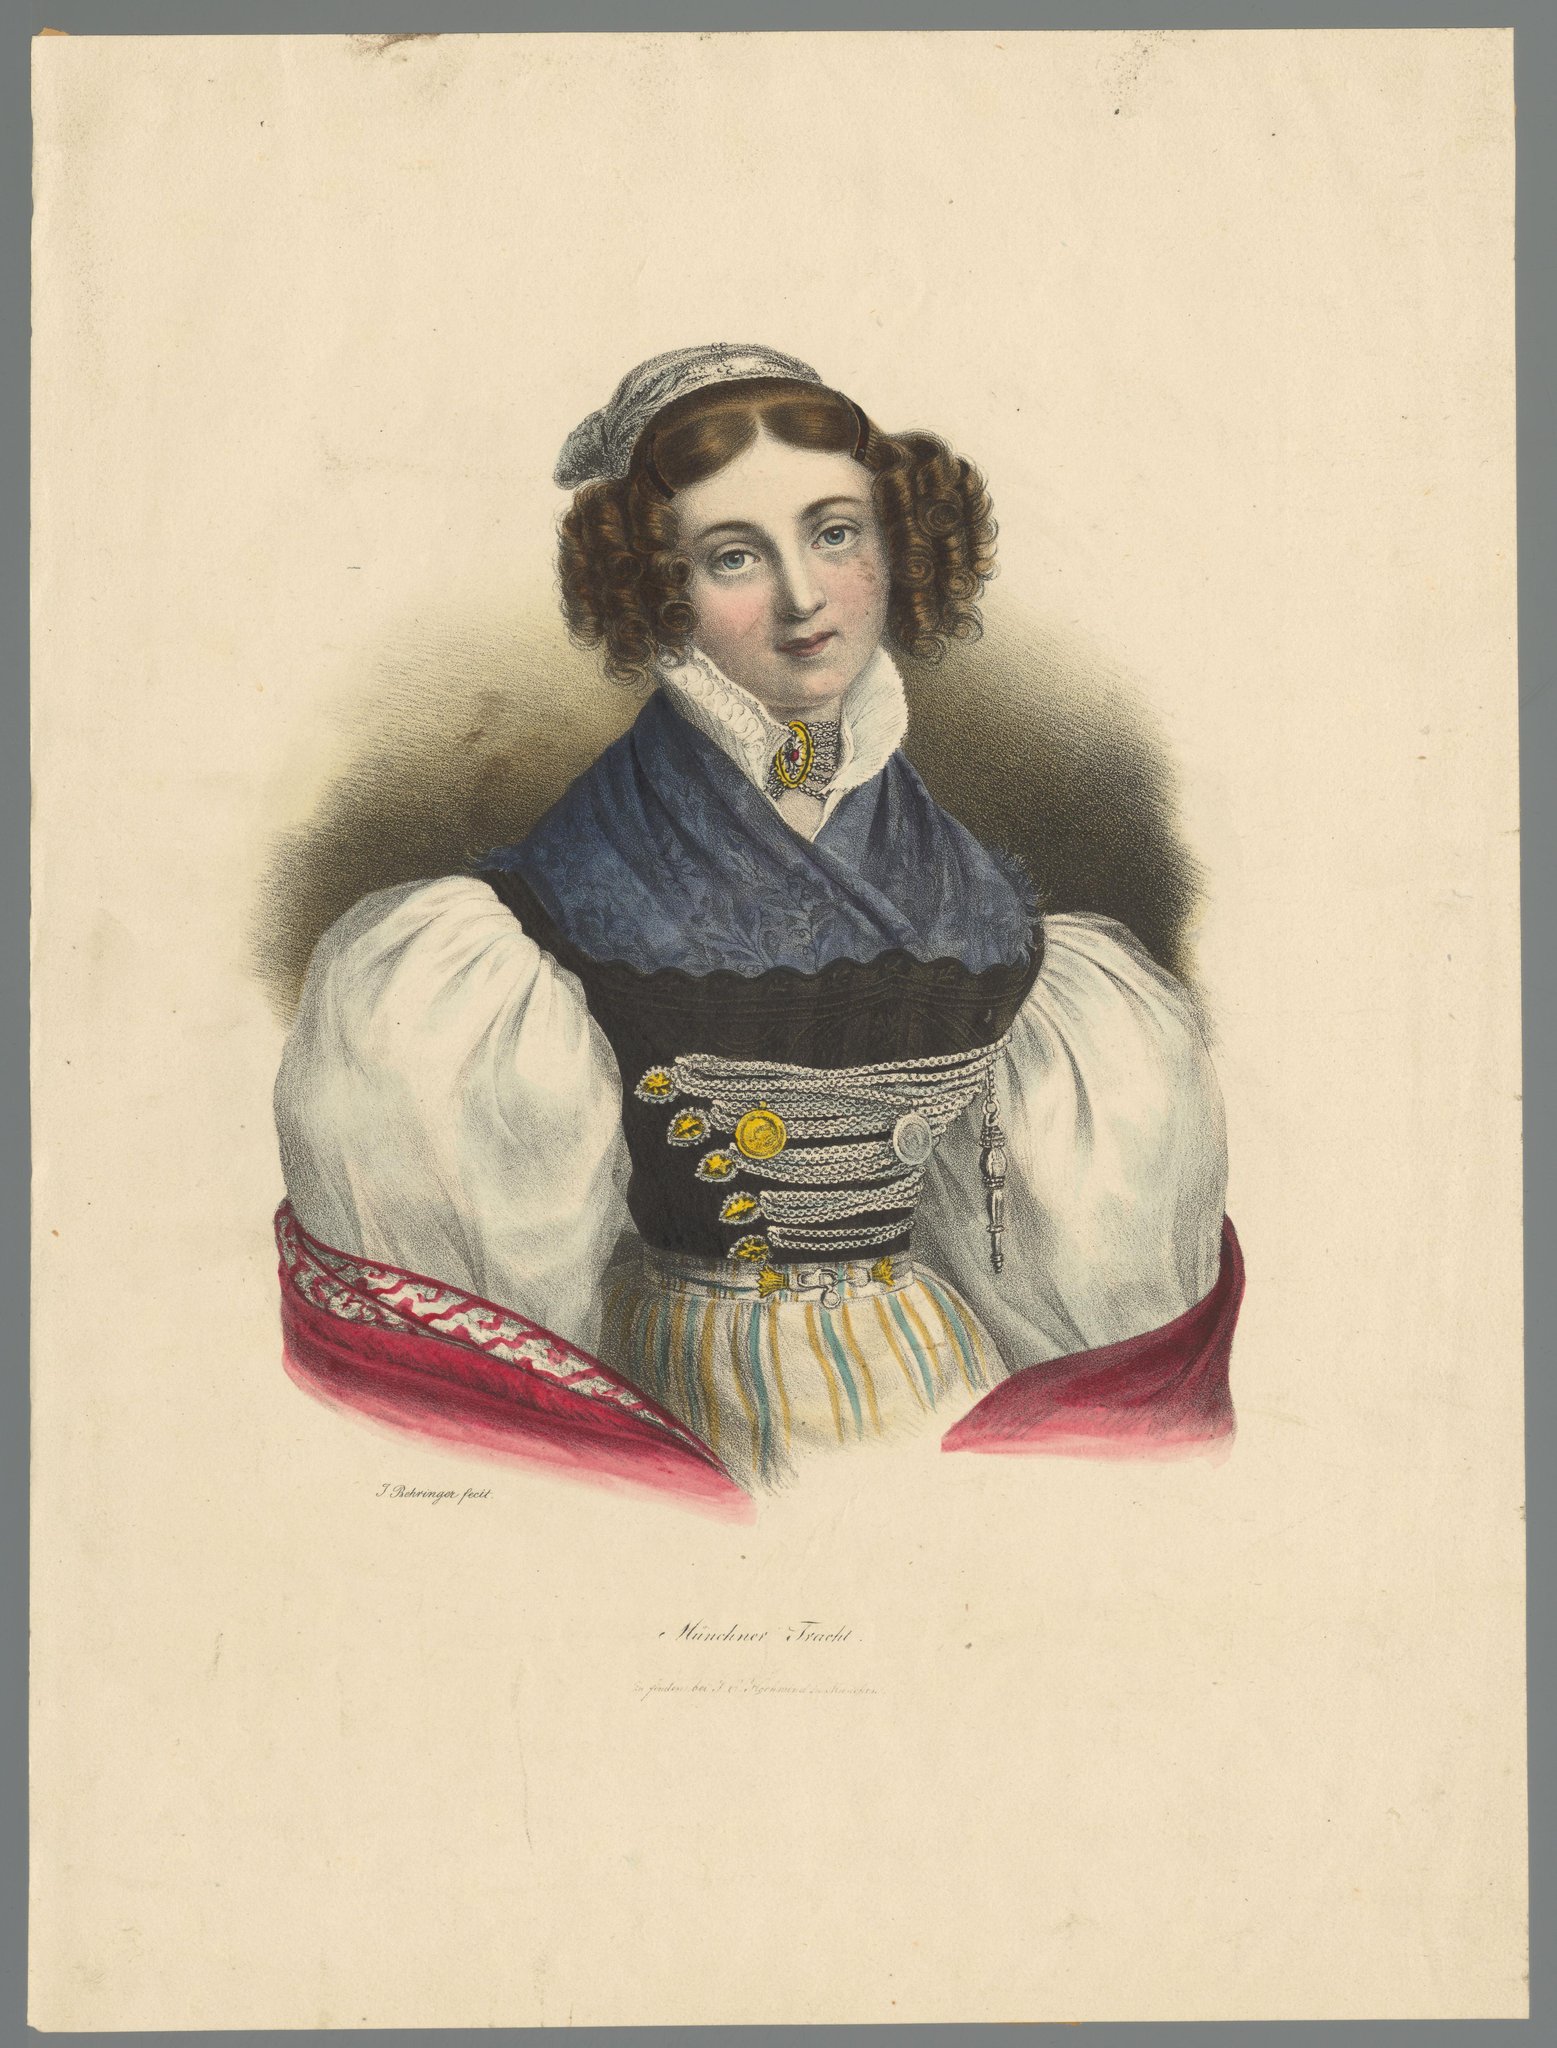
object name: print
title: Vrouw in klederdracht uit München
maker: johann christian hochwind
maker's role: publisher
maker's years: -1854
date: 1825-1875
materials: paper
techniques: hand coloring, lithograph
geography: munich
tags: adult woman, folk costume, regional costume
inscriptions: collector's mark: Lugt 2228